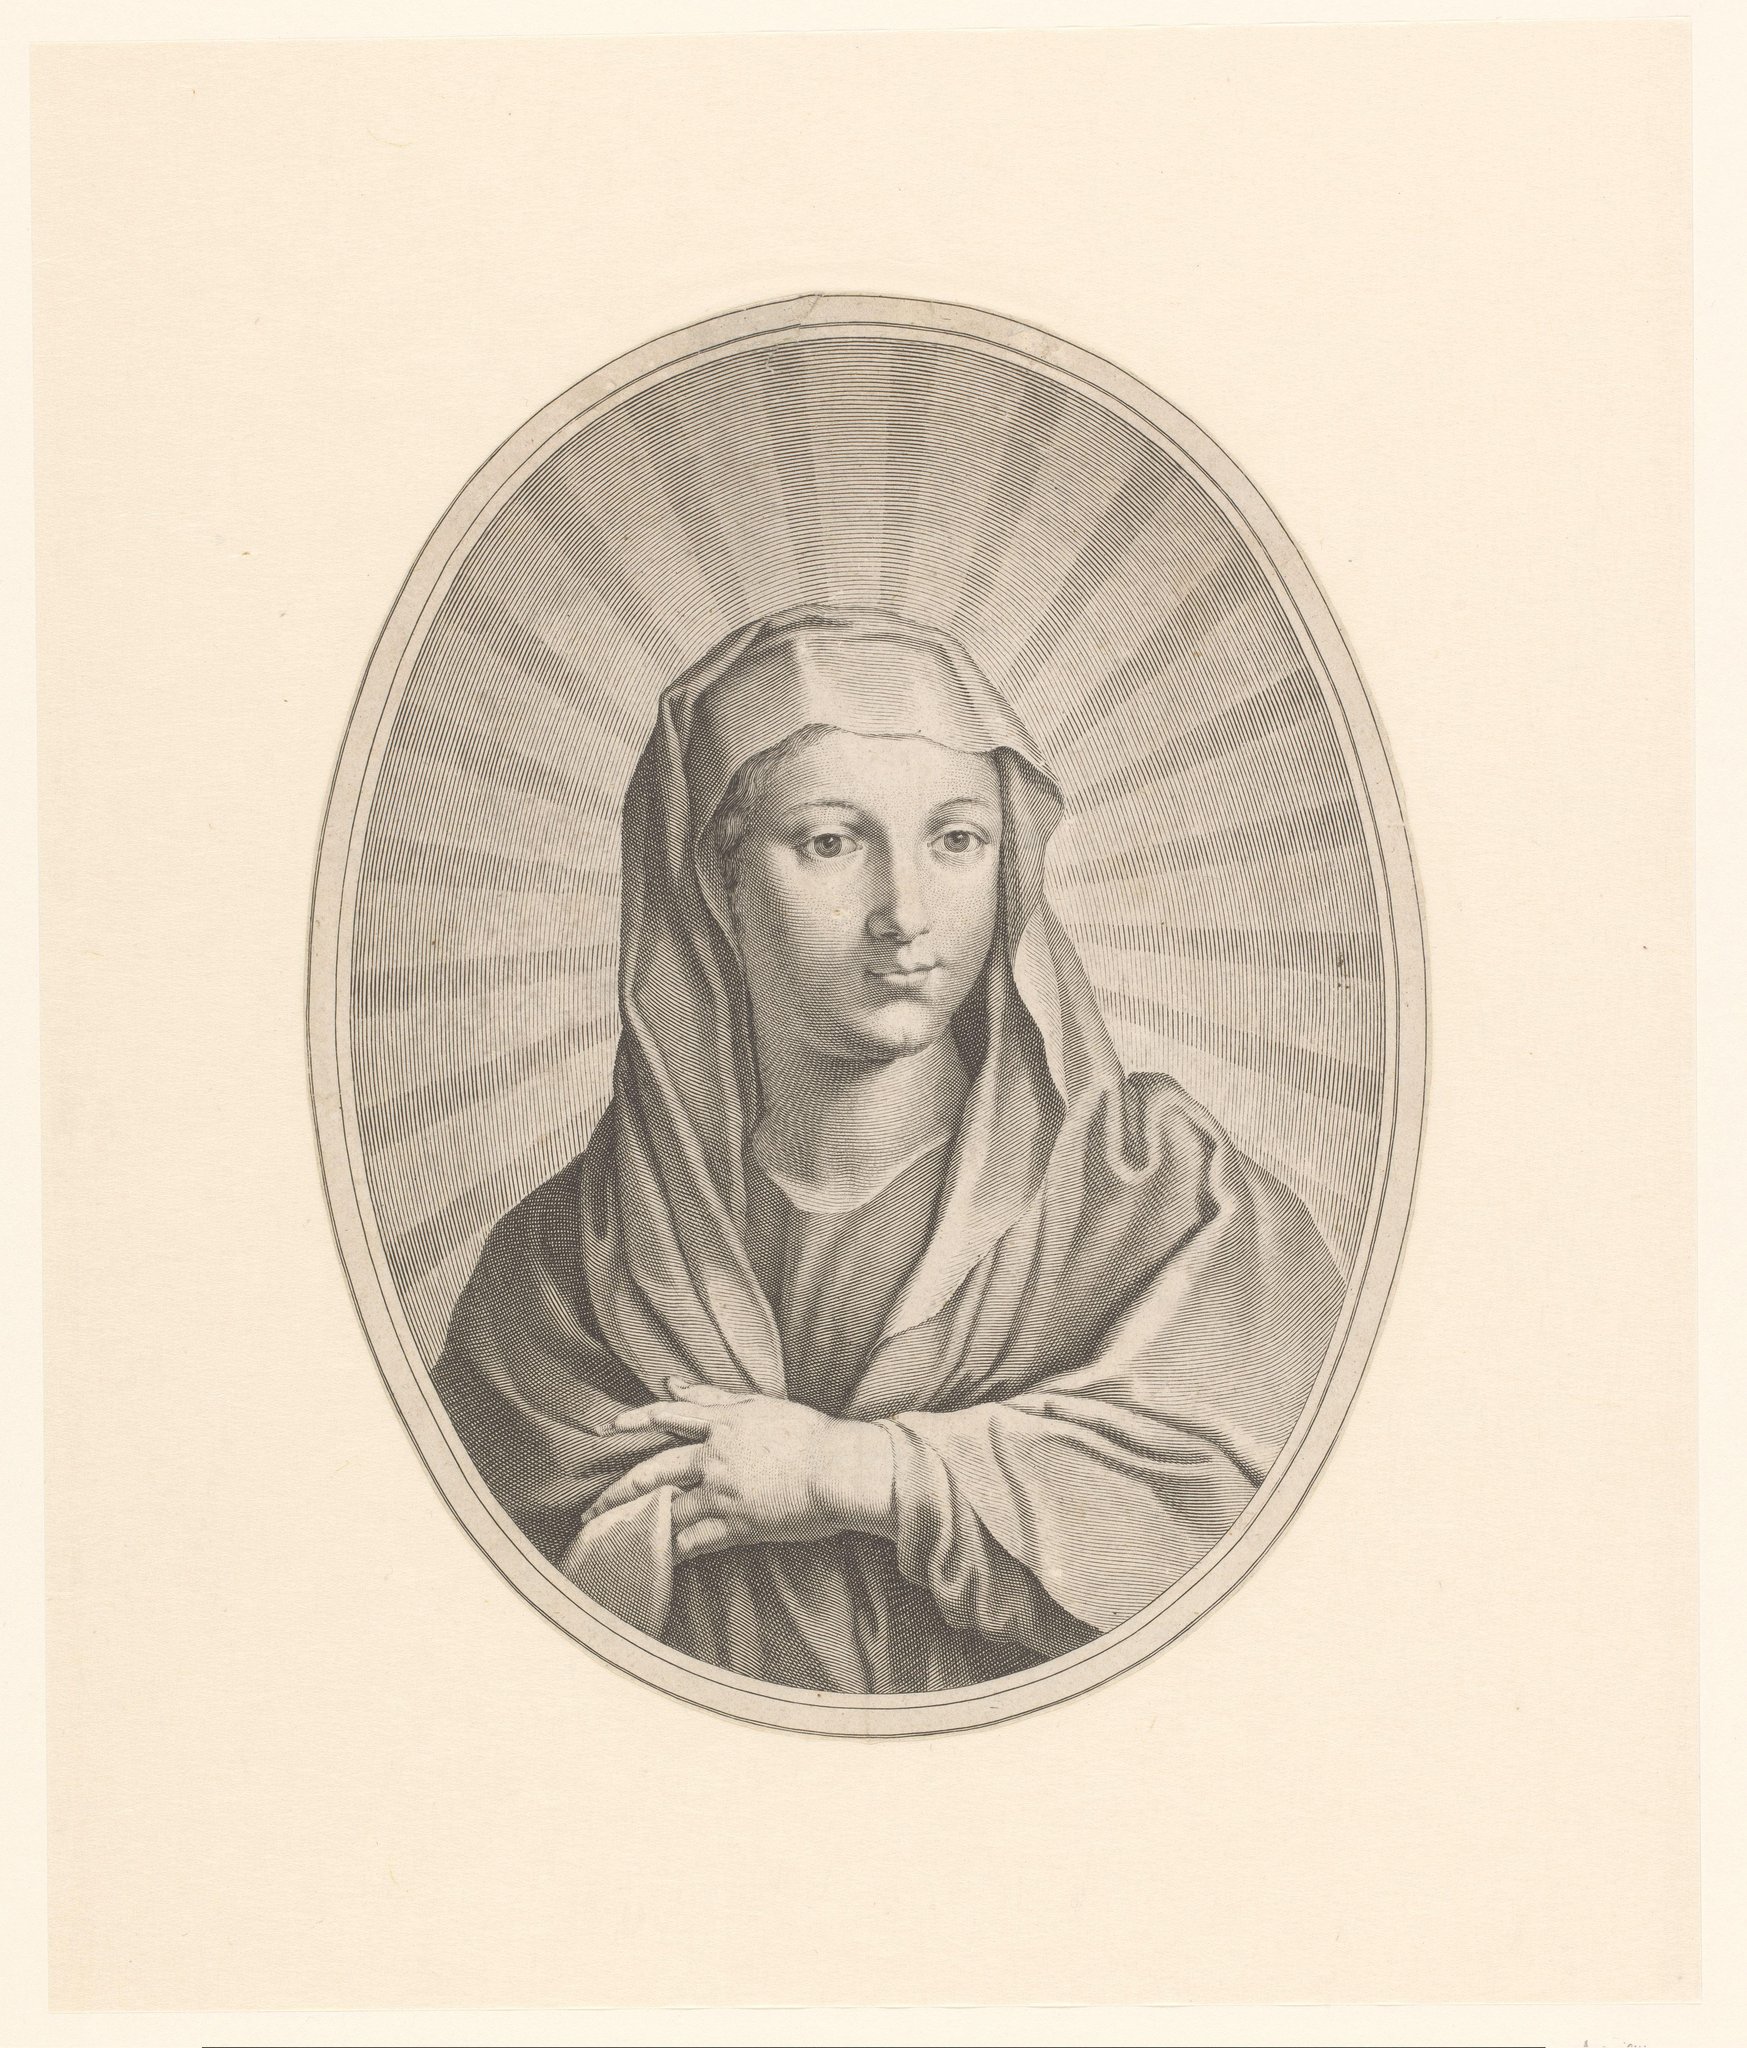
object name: print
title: Maagd Maria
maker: Anonymous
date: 1600-1699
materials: paper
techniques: engraving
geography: france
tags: 'portraits' of mary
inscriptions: collector's mark: Lugt 2228